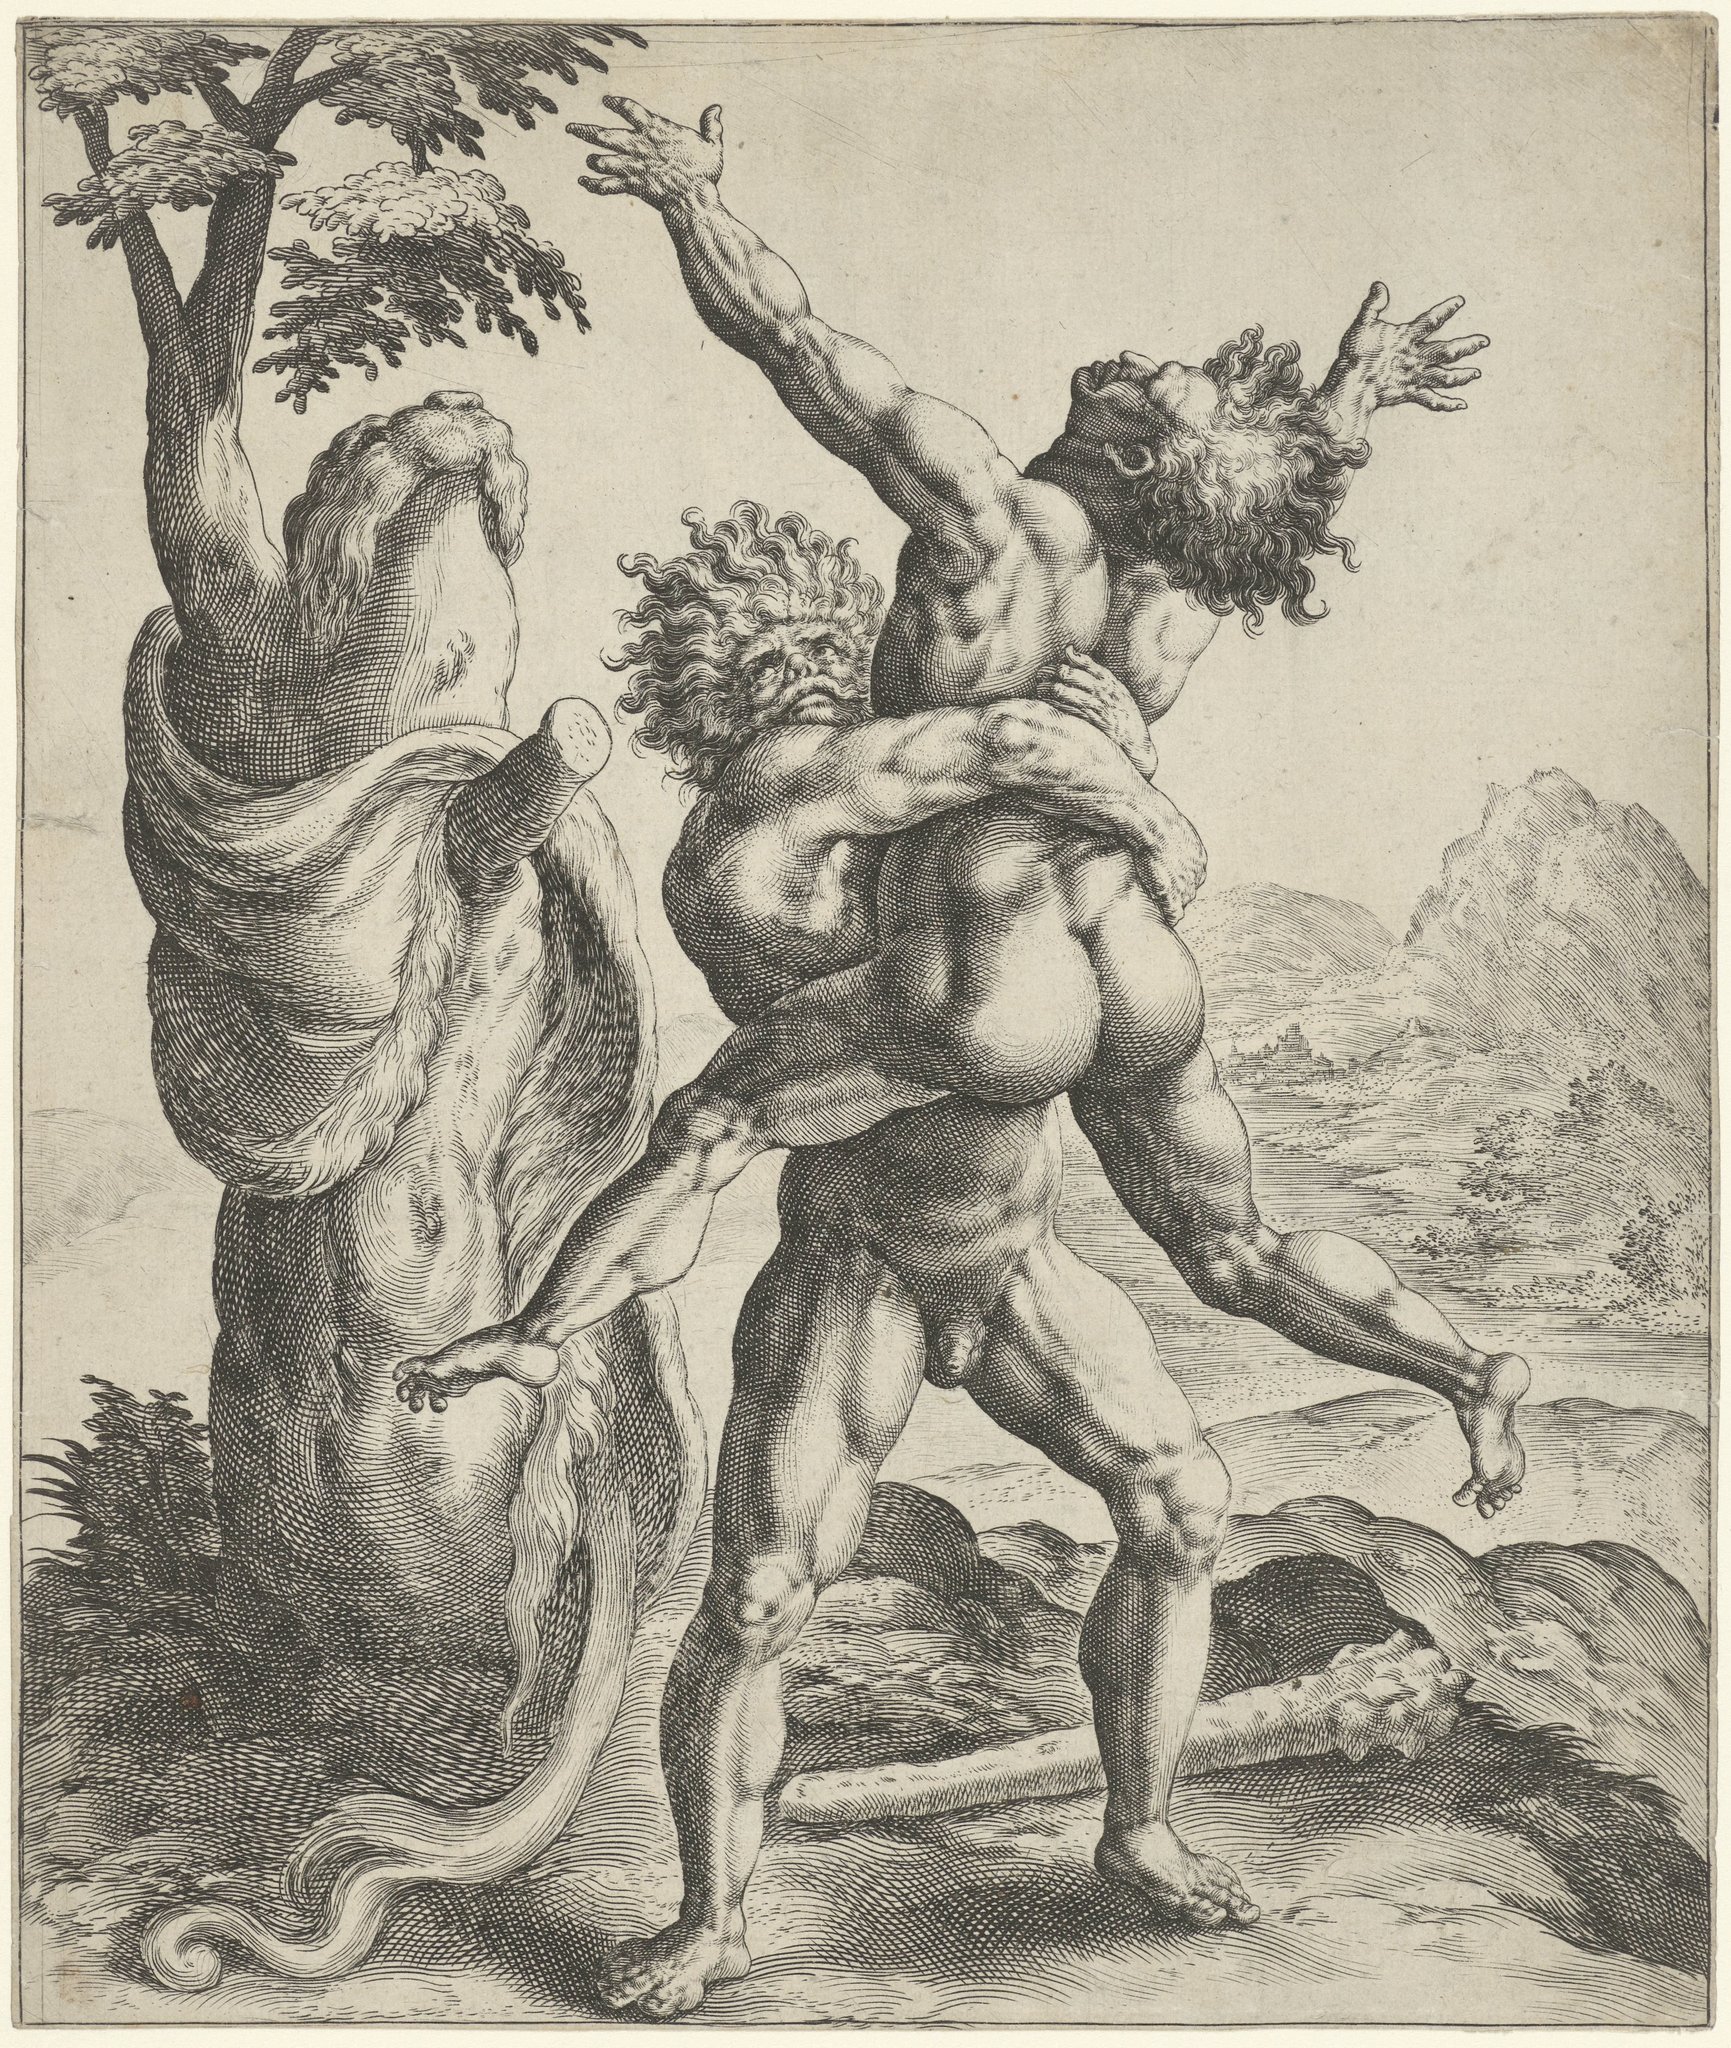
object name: print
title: Hercules worstelt met Antaeus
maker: crispijn van de passe (i)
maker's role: draughtsman, print maker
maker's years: 1564-1637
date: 1574-1637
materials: paper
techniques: engraving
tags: the giant antaeus is lifted in the air and crushed to death by hercules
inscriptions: collector's mark: Lugt 2228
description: Hercules gaat een worstelwedstrijd aan met Antaeus en tilt de reus op. Antaeus was onoverwinnelijk zolang hij in aanraking bleef met de aarde, waaraan hij zijn kracht ontleende. Aan de boomstam hangt Hercules' leeuwenhuid en op de grond ligt zijn knots.